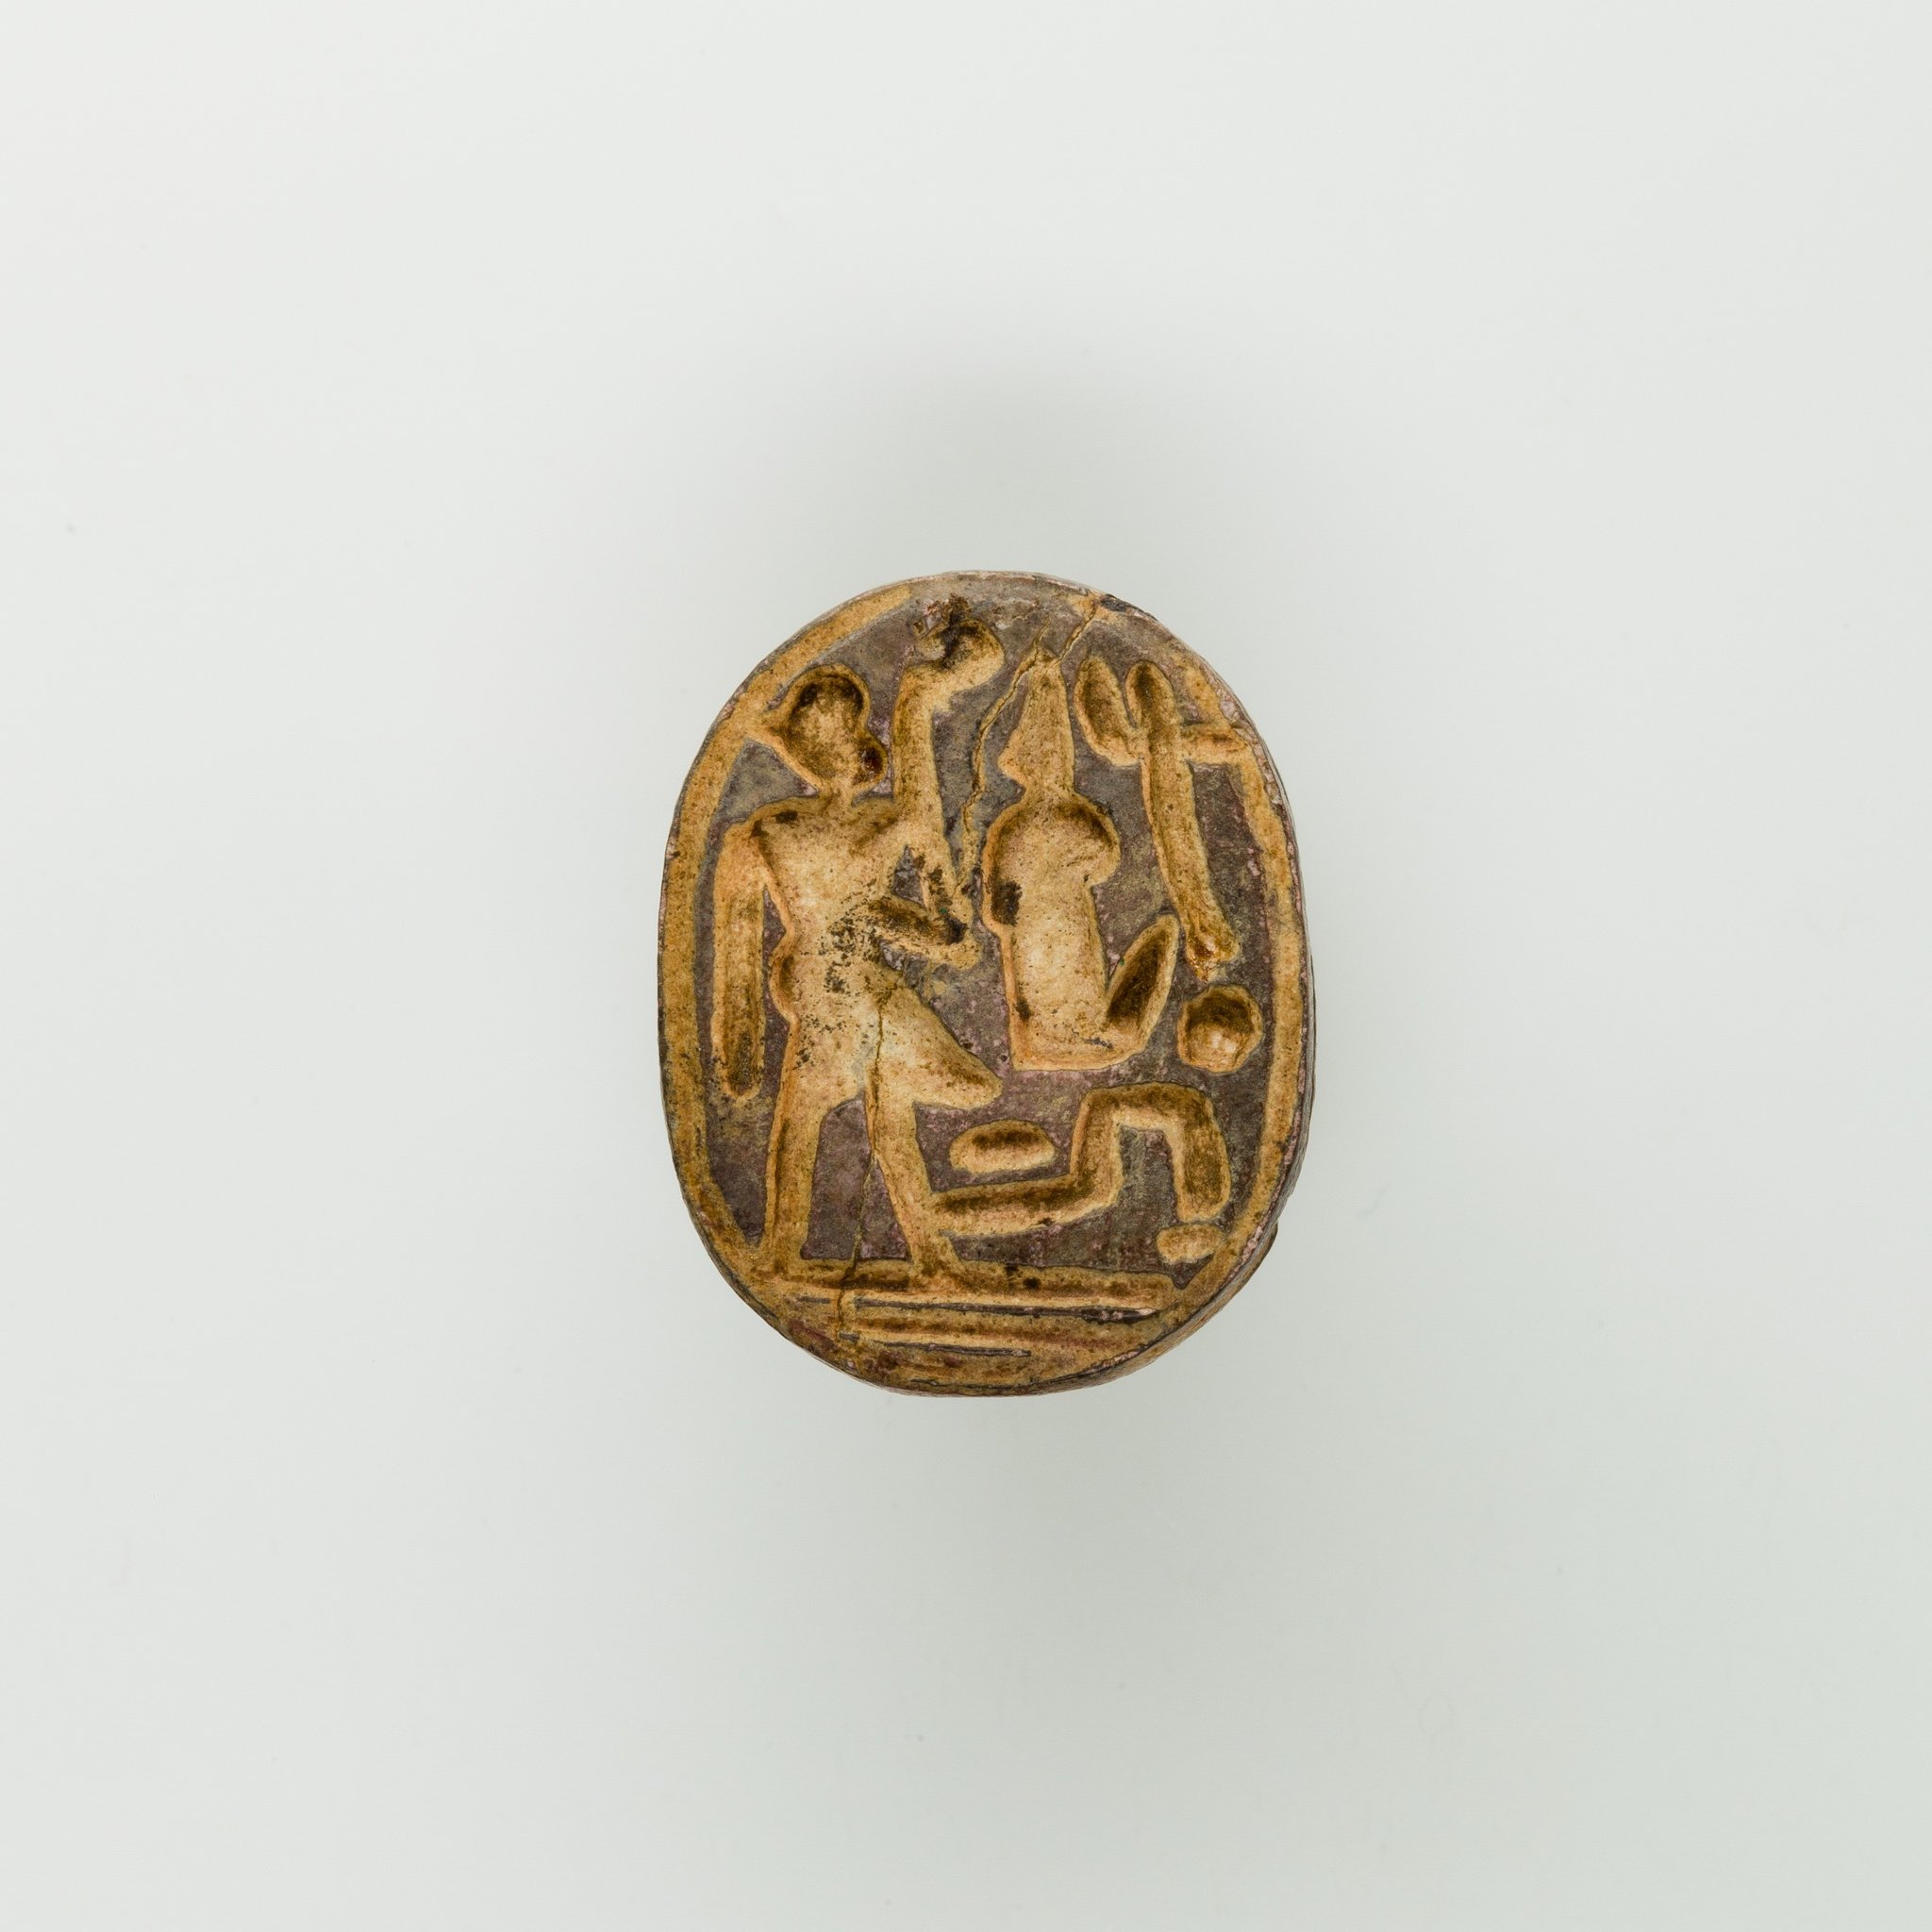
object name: scarab, ramesses ii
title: Scarab of Ramesses II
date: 1295-1070 BCE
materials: stone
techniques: glazing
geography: egypt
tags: hieroglyphs,scarabs